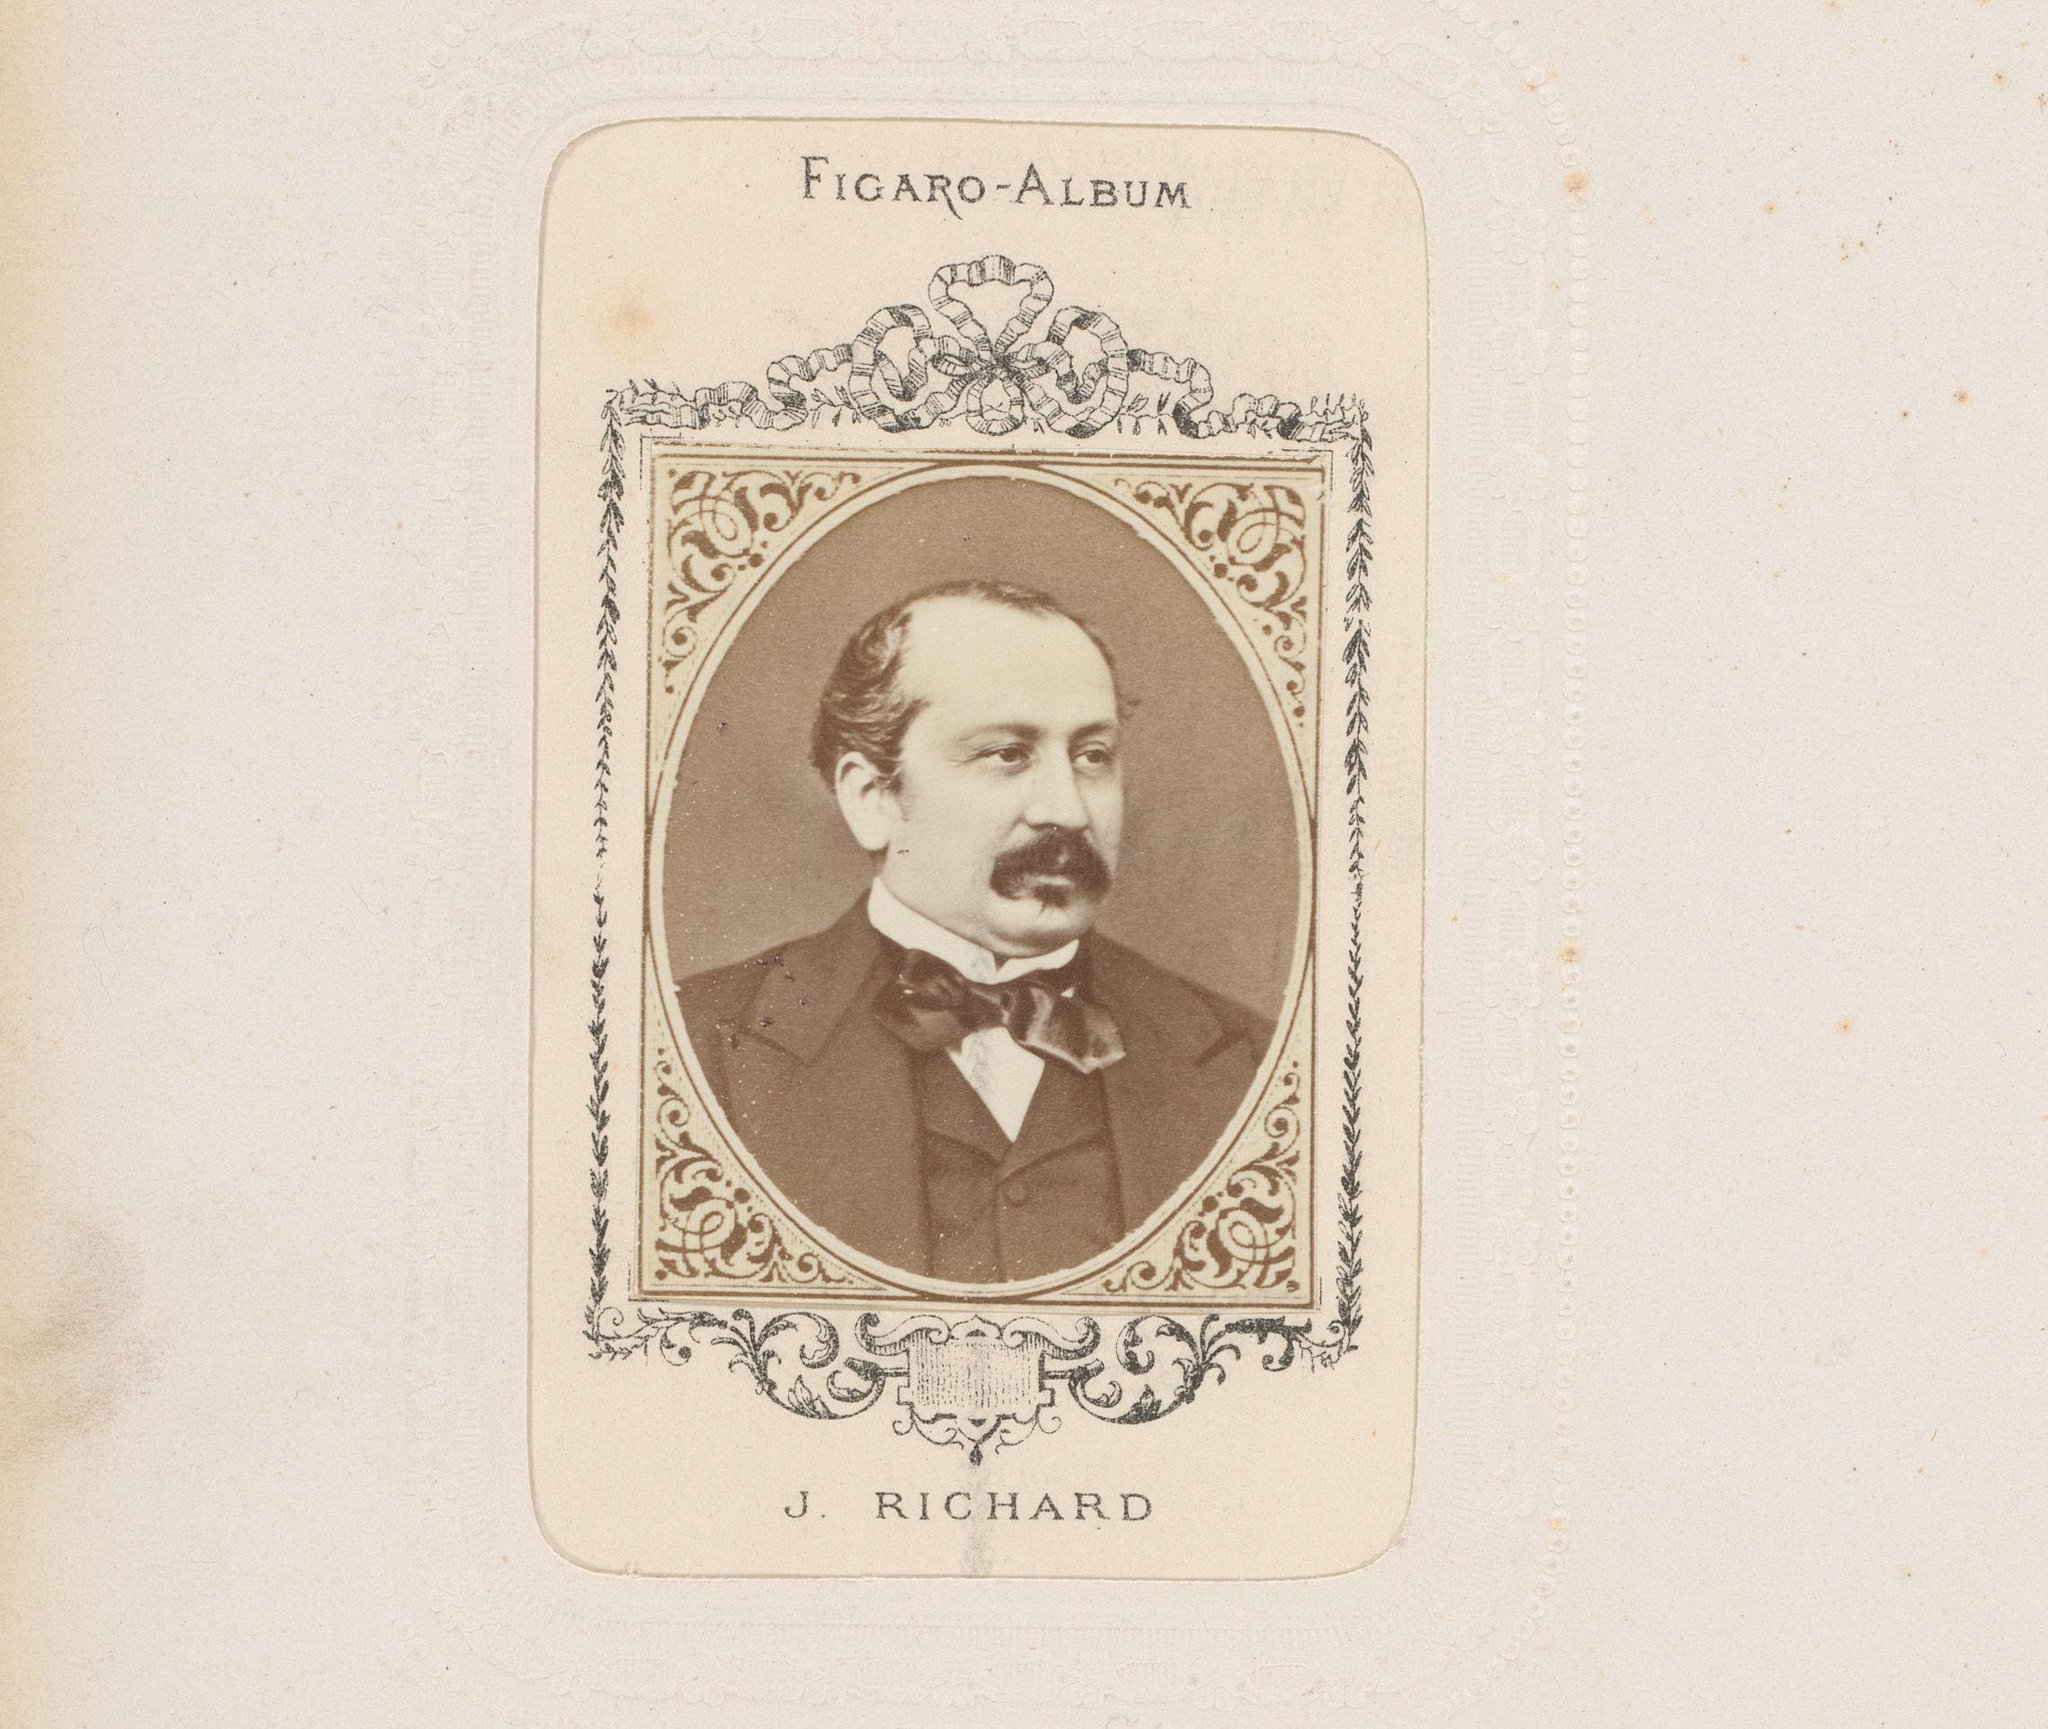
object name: album leaf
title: Fotoreproductie van een portret van J. Richard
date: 1860-1900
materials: cardboard, photographic support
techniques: albumen print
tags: paris, historical persons, writer, poet, author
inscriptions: inscription: ‘Figaro-Album/ J. Richard/ Liébert Phot.’